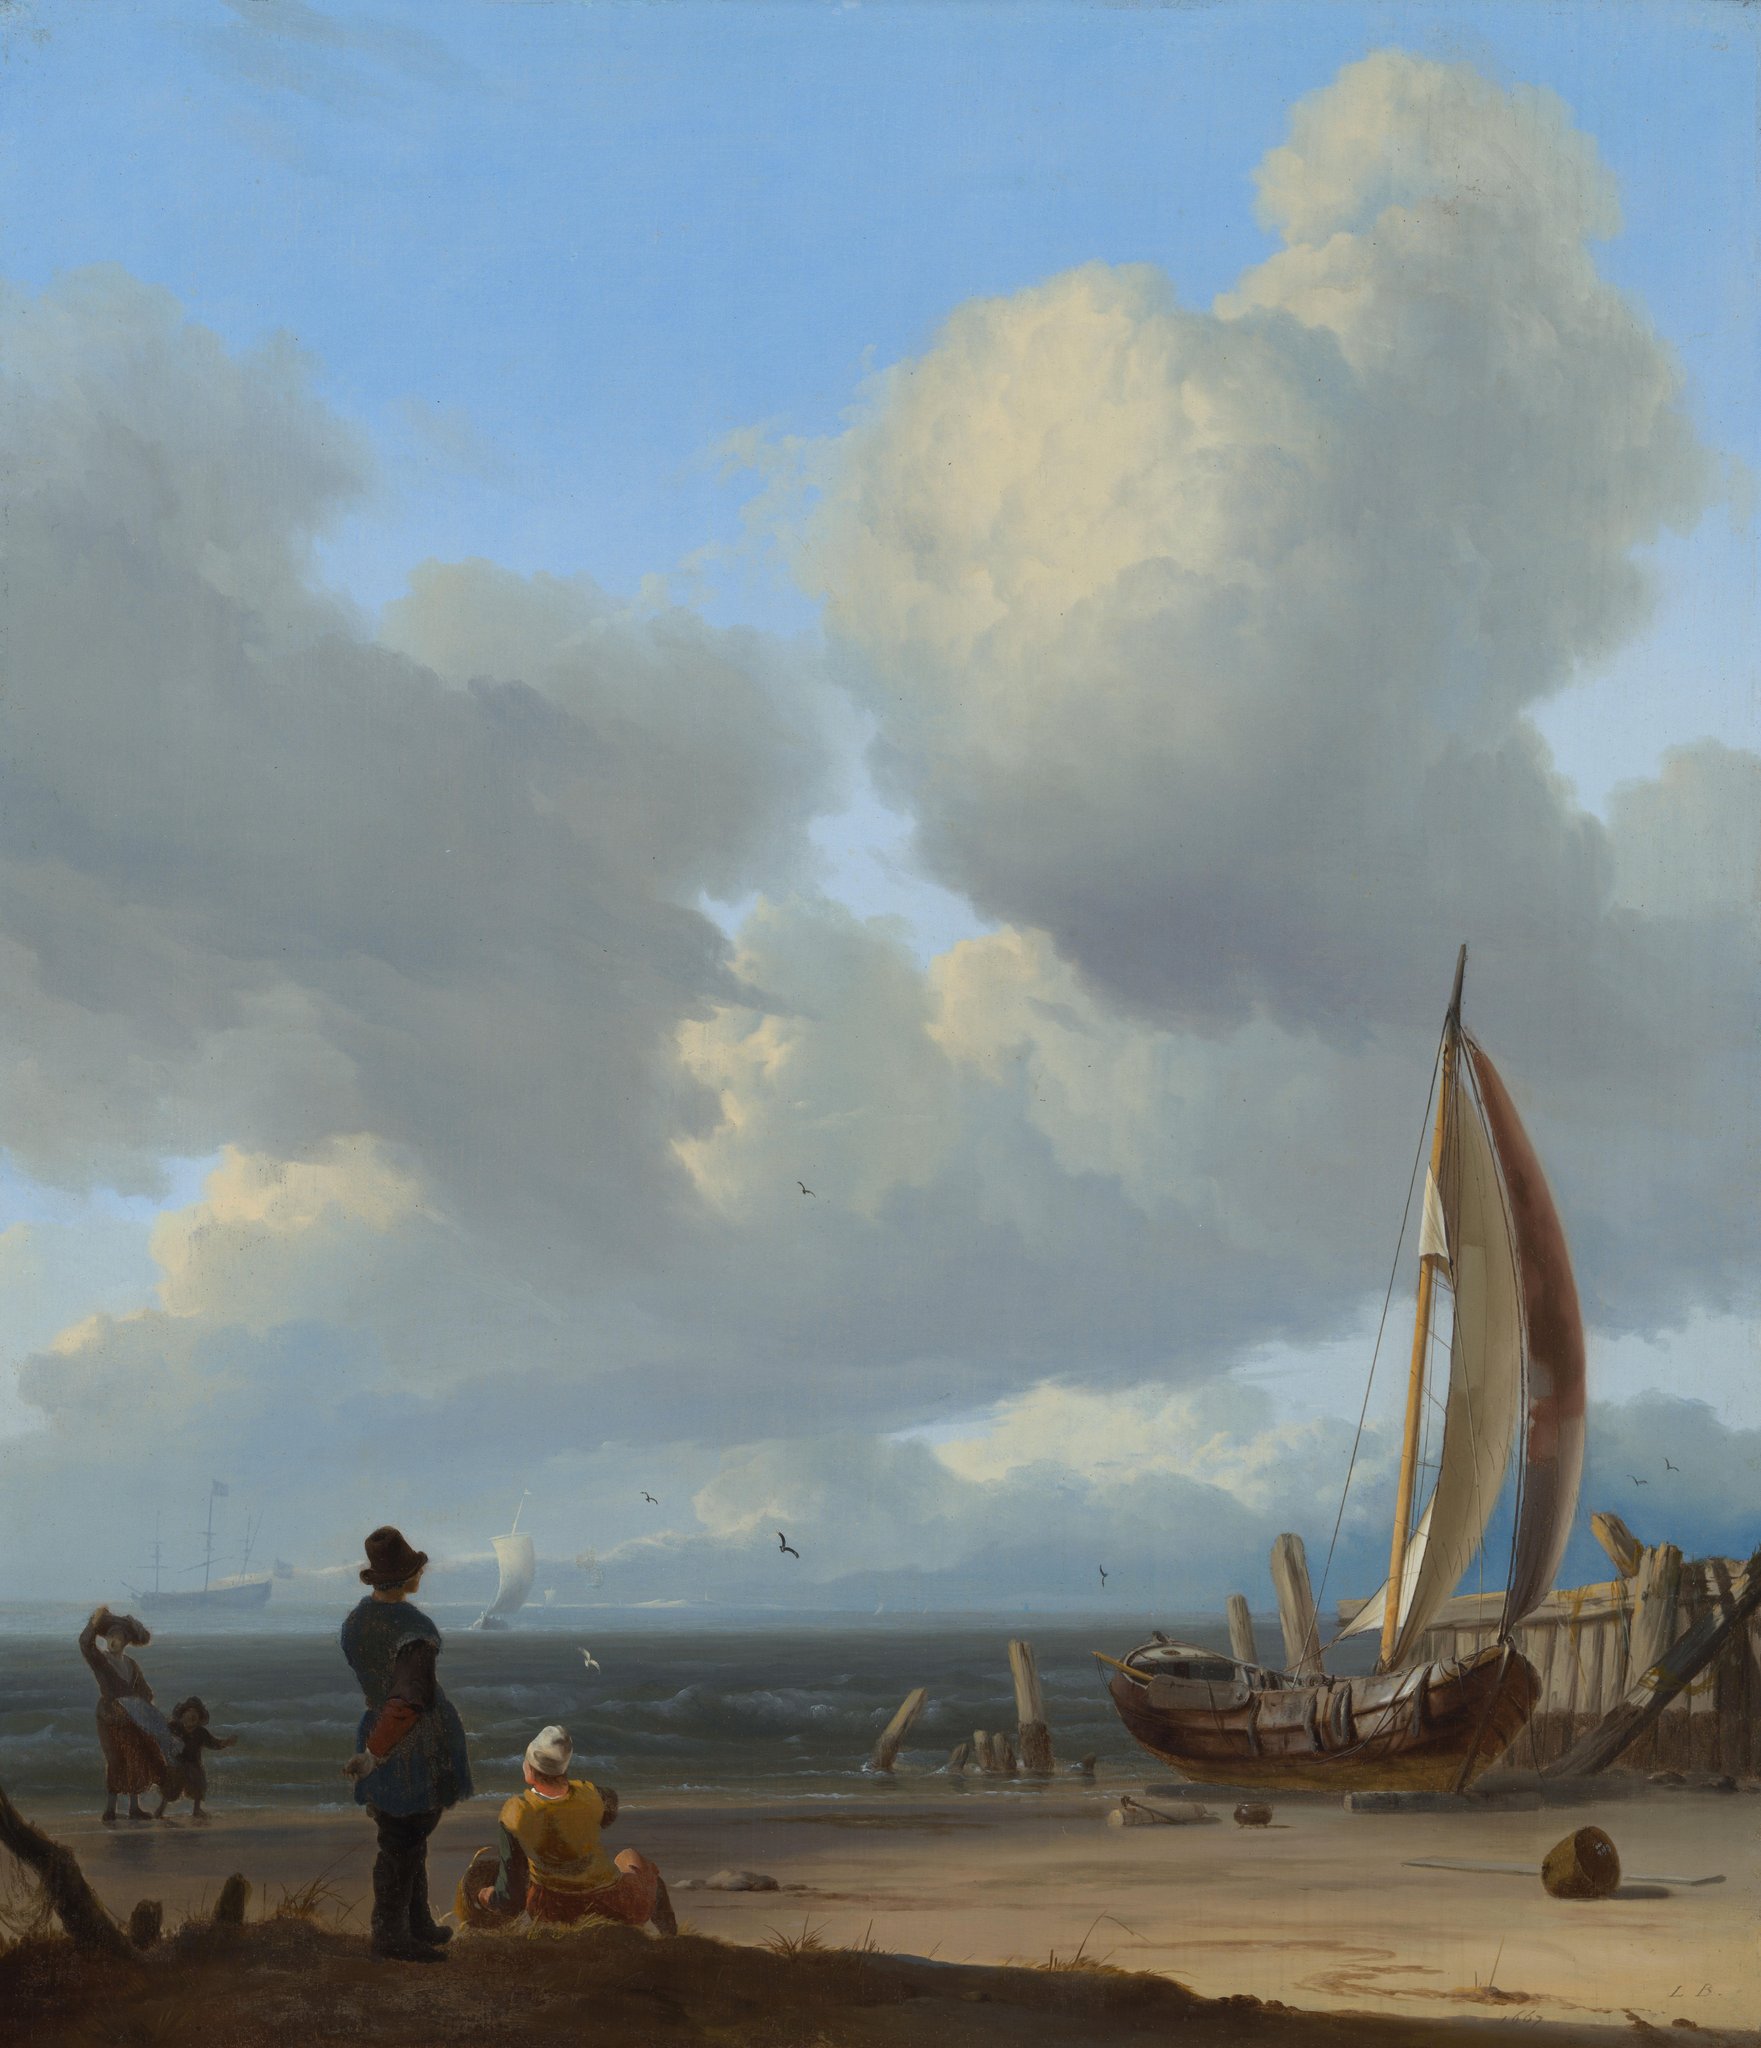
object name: painting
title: A Seascape with Figures by a Boat on a Shore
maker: ludolf bakhuysen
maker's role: draughtsman, print maker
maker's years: 1631-1708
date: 1667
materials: canvas, oil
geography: amsterdam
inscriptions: signature: ‘L.B. / 1667’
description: Ludolf Bakhuysen was famous in his own day for his renderings of dramatic storms; however, here he chose to paint a tranquil scene. On the beach is a kaag, a type of boat used to load, provision and unload large seagoing sailing vessels, such as the merchant ship in the background.